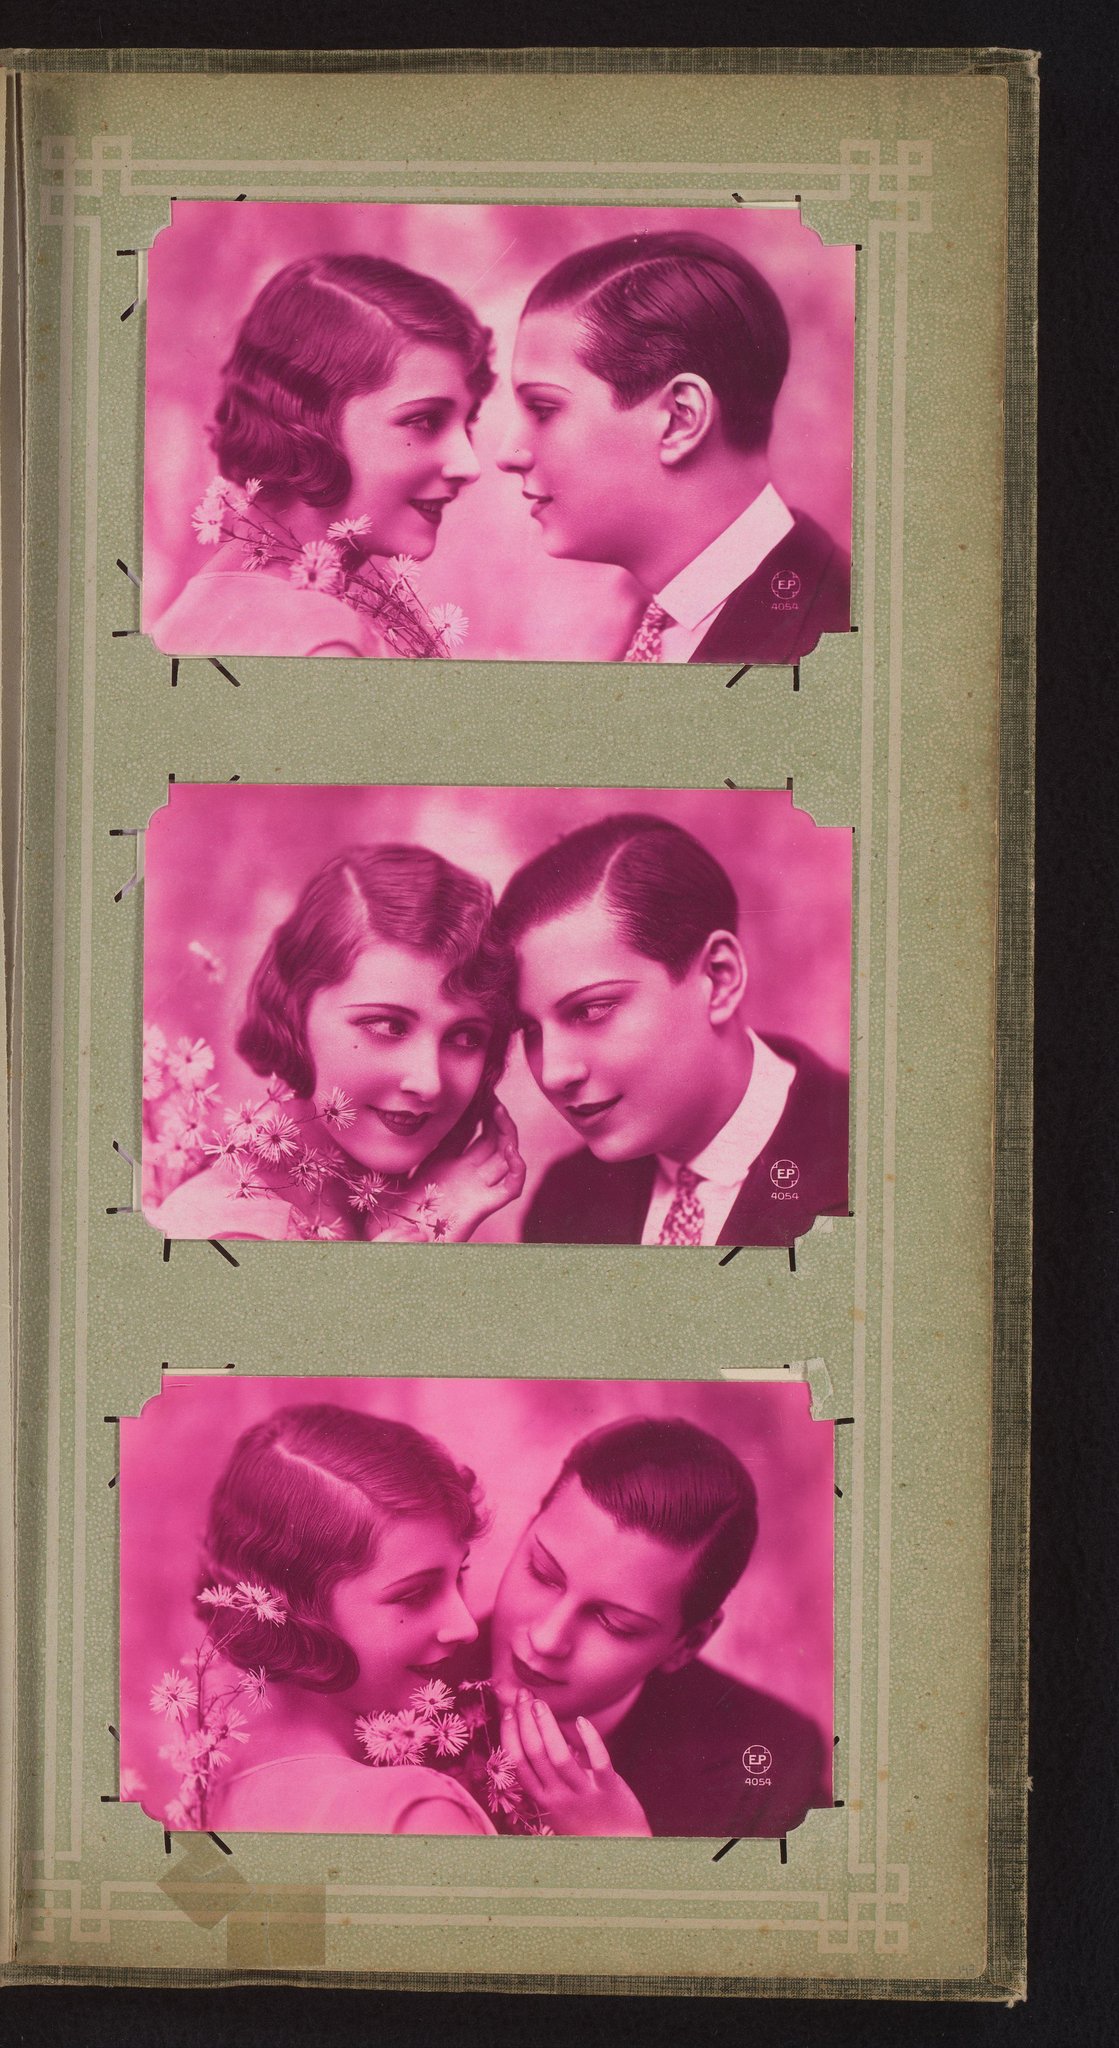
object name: ansichtkaart, prentbriefkaart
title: Drie portretten van een paar geliefden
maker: Anonymous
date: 1900-1930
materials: cardboard, photographic support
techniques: gelatin silver print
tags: historical persons - bb - woman, historical persons, couple of lovers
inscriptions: monogram: ‘EP’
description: Deze foto's maken deel uit van een album.